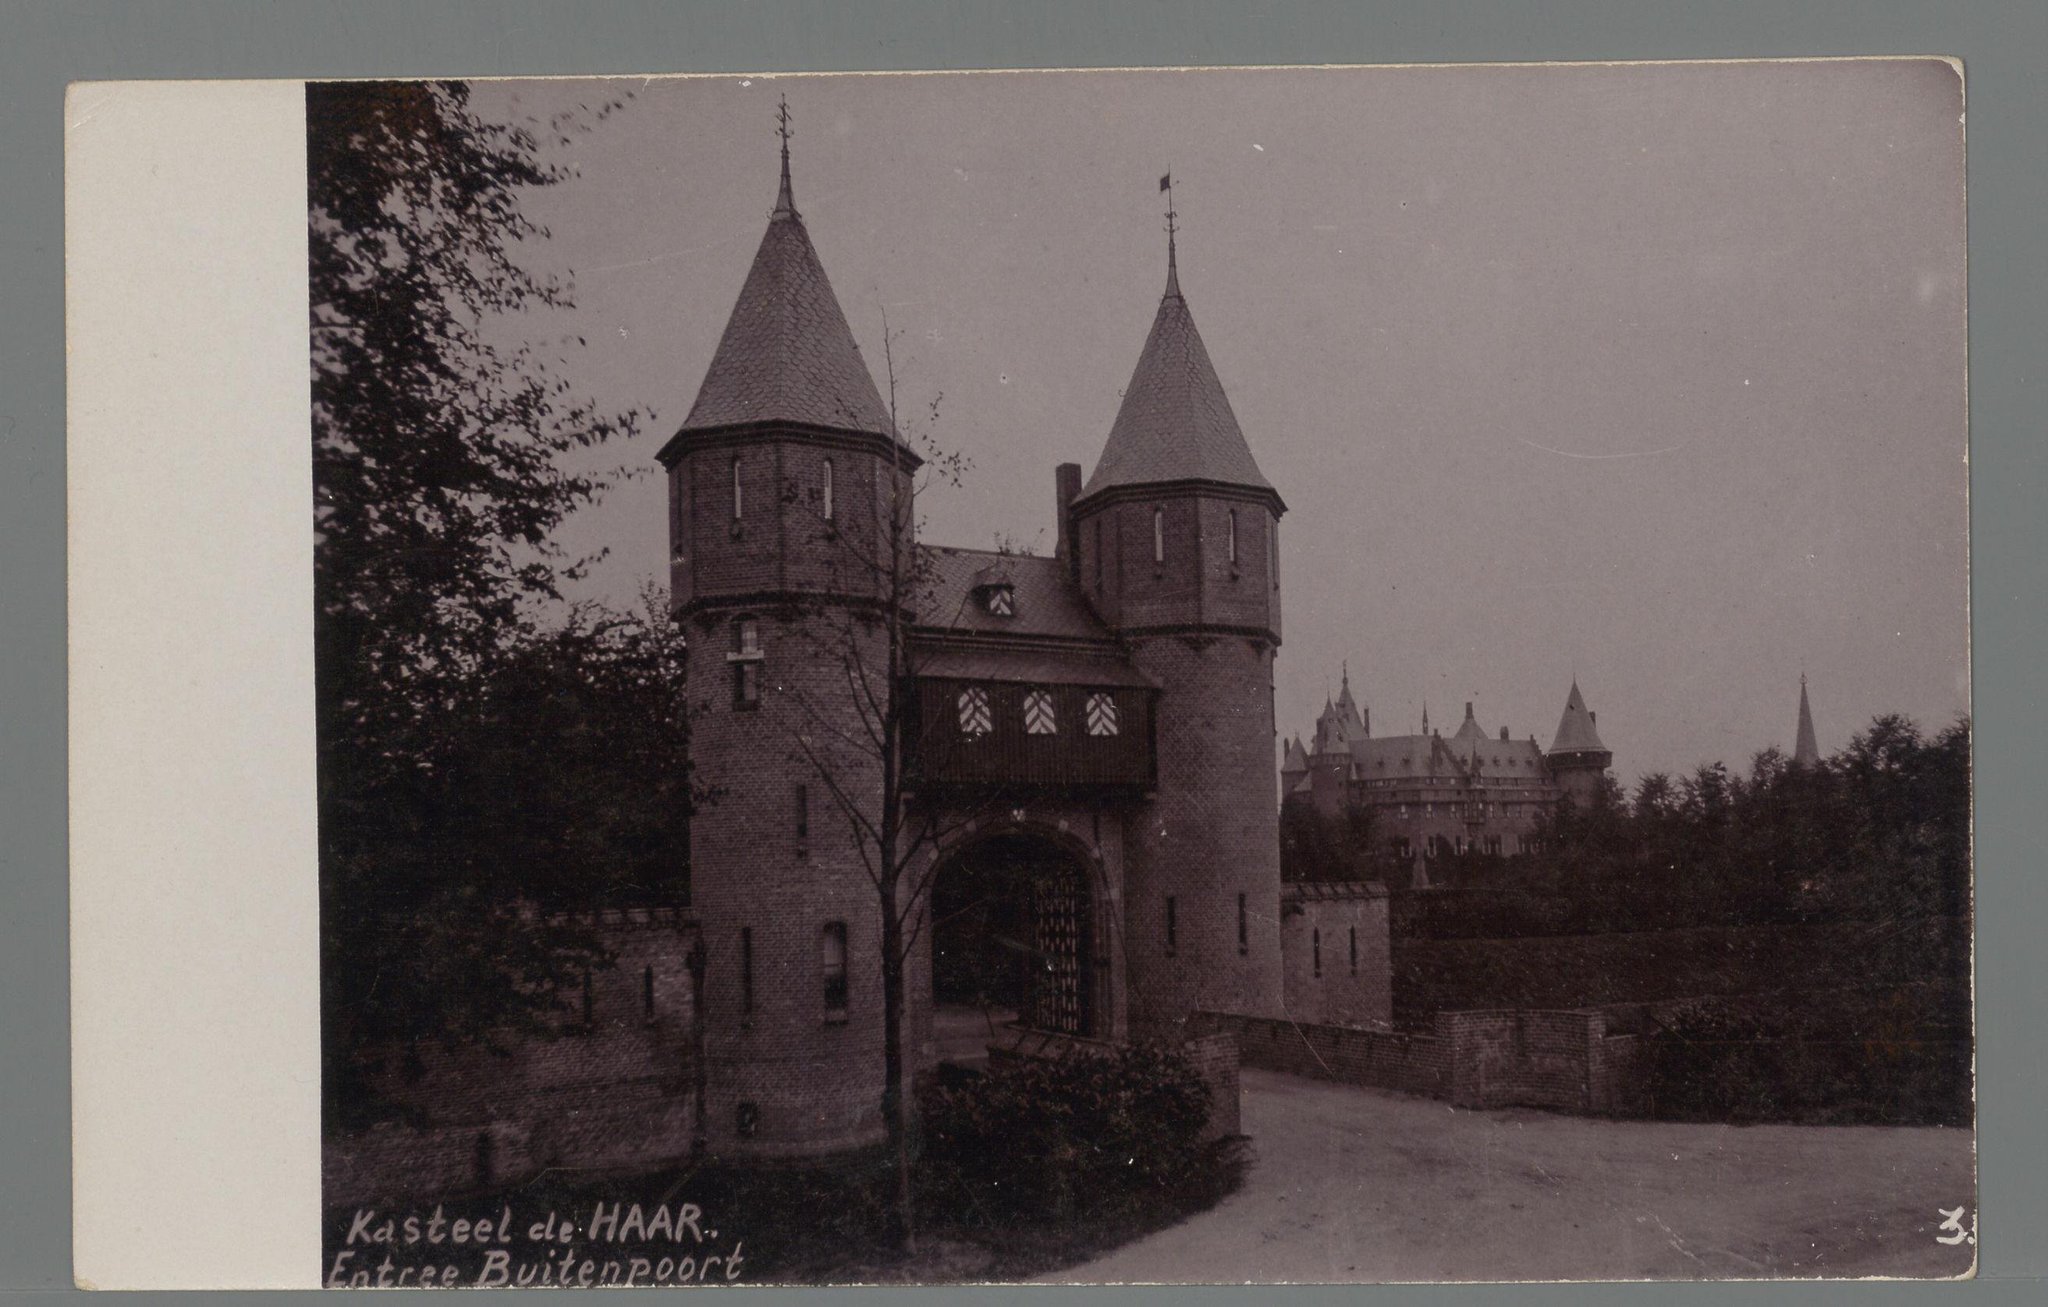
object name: ansichtkaart, prentbriefkaart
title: Kasteel de Haar. Entree buitenpoort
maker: Anonymous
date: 1900-1930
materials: paper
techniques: collodion silver print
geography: haarzuilens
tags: castle, gate, entrance